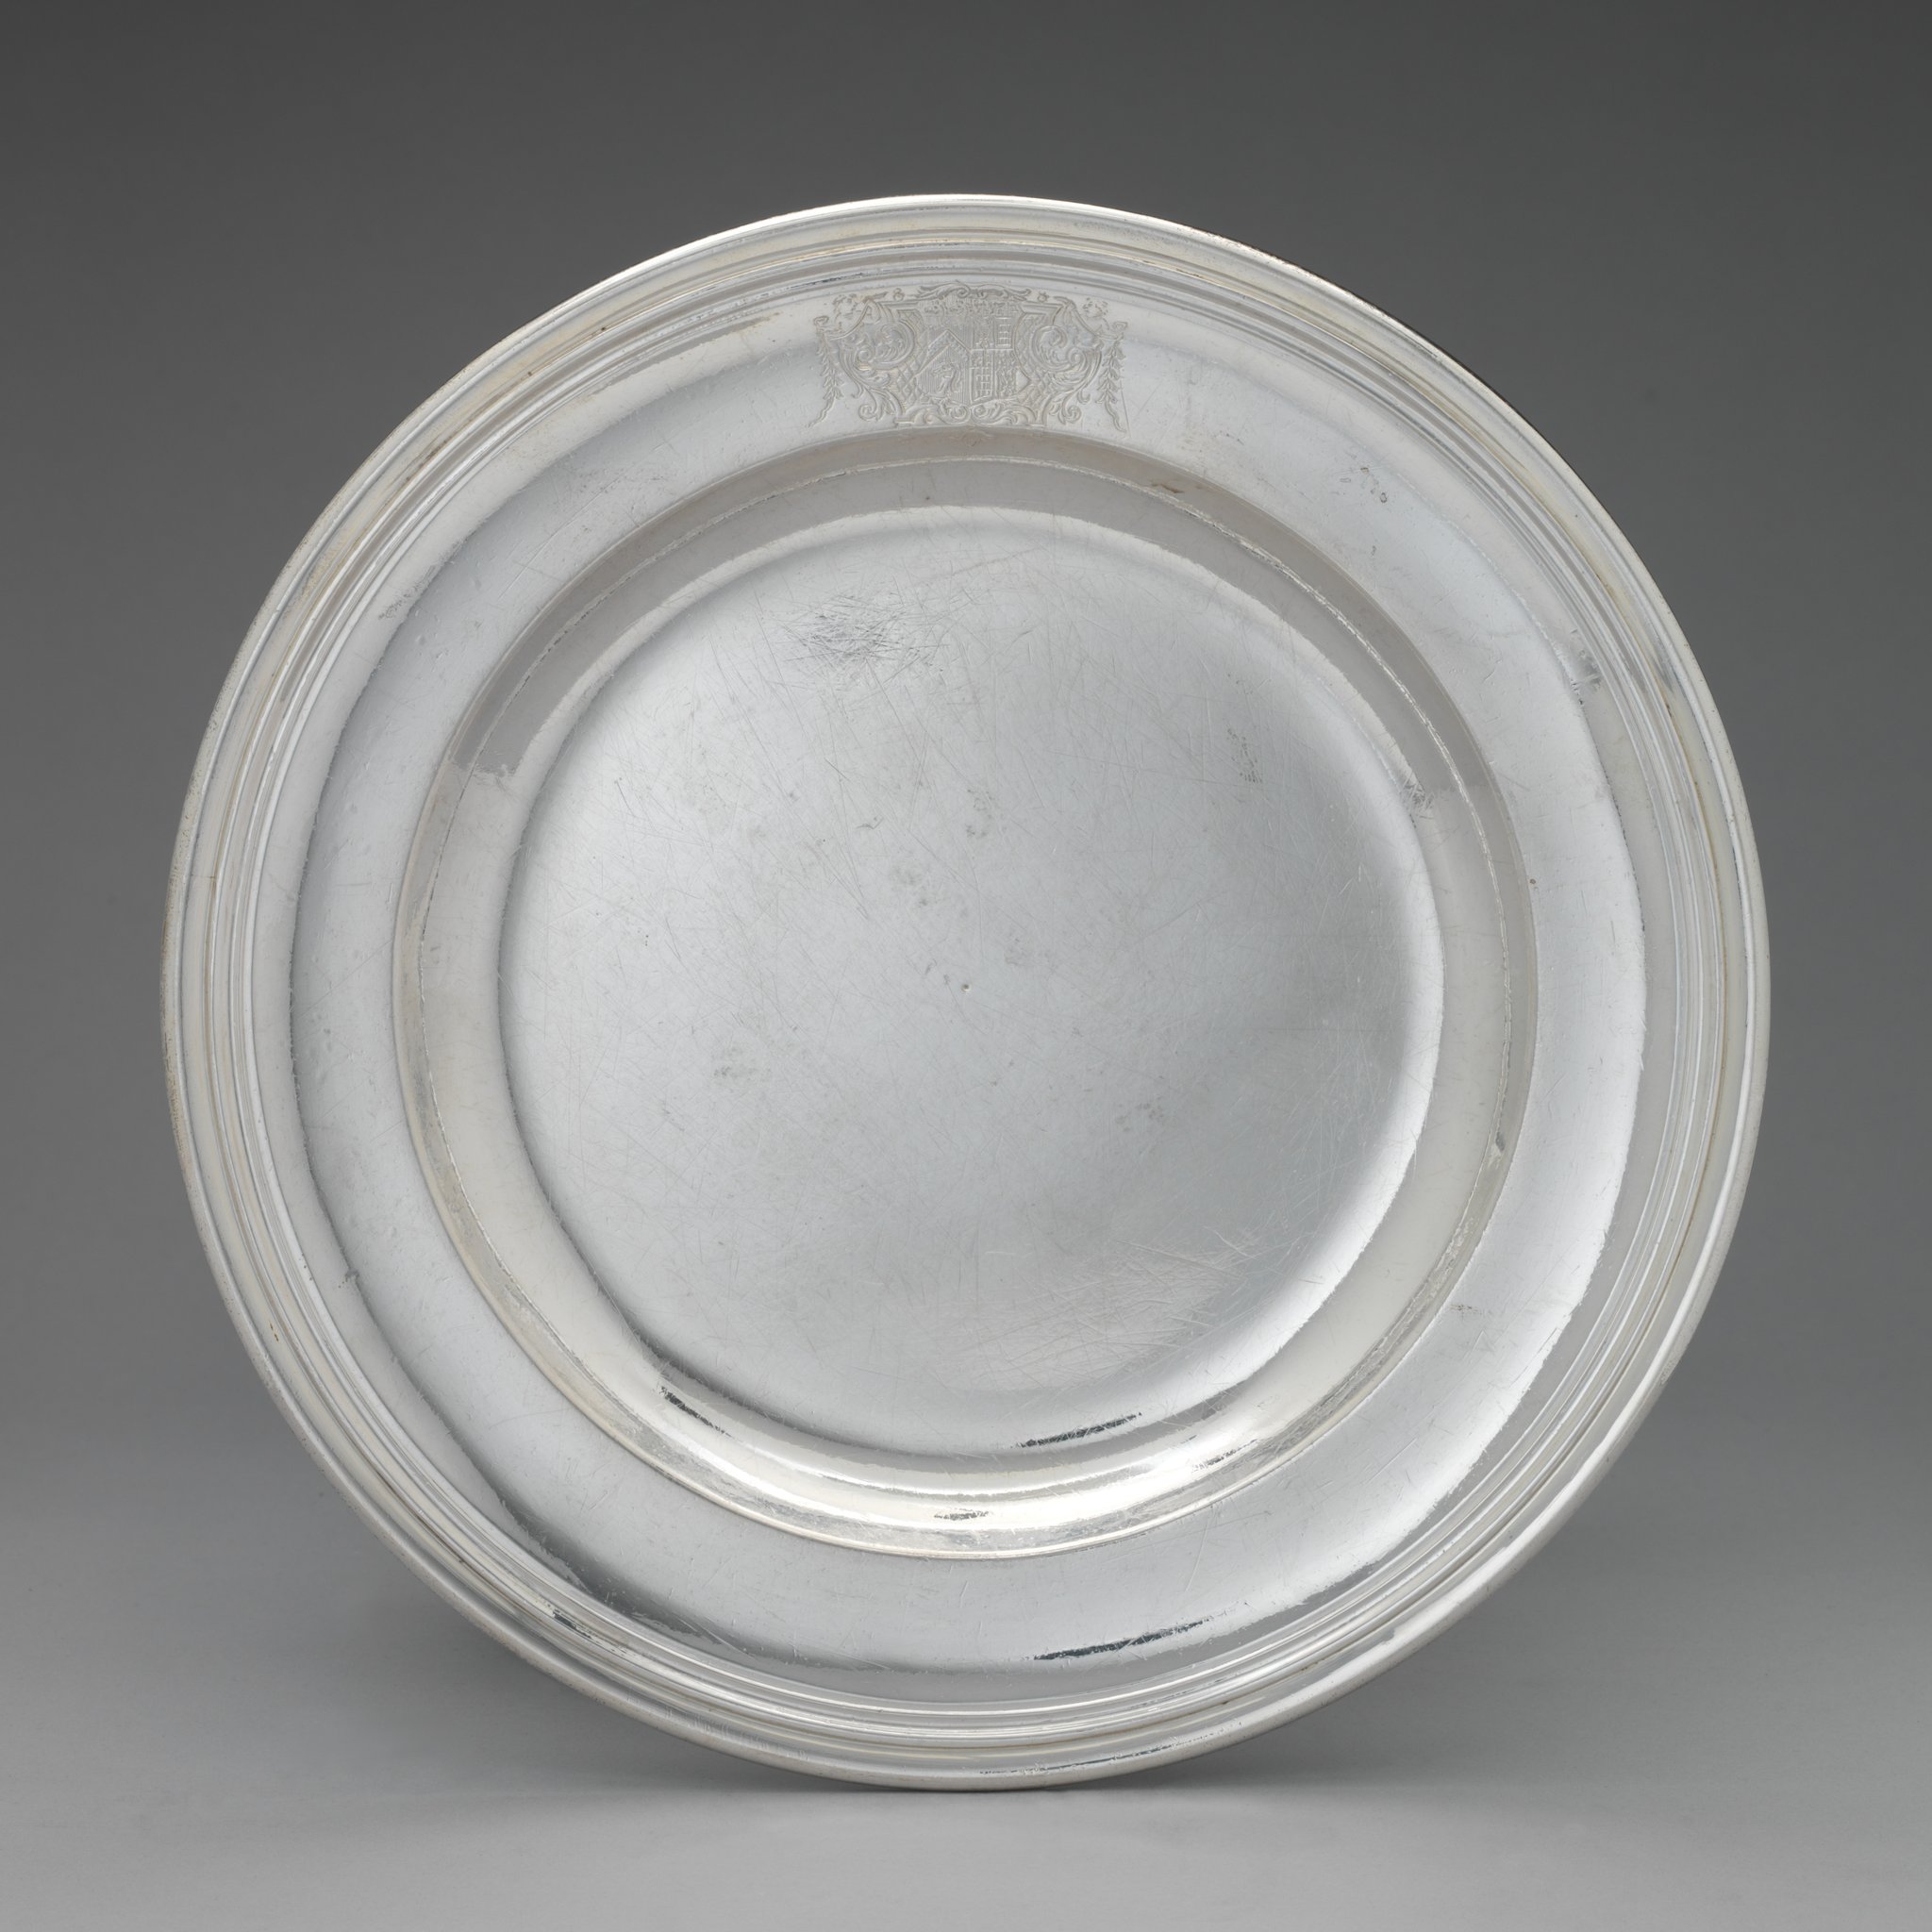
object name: plate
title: Plate (one of a set of twelve)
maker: thomas farren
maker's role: maker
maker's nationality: british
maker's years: 1703-1743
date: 1715-1716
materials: silver